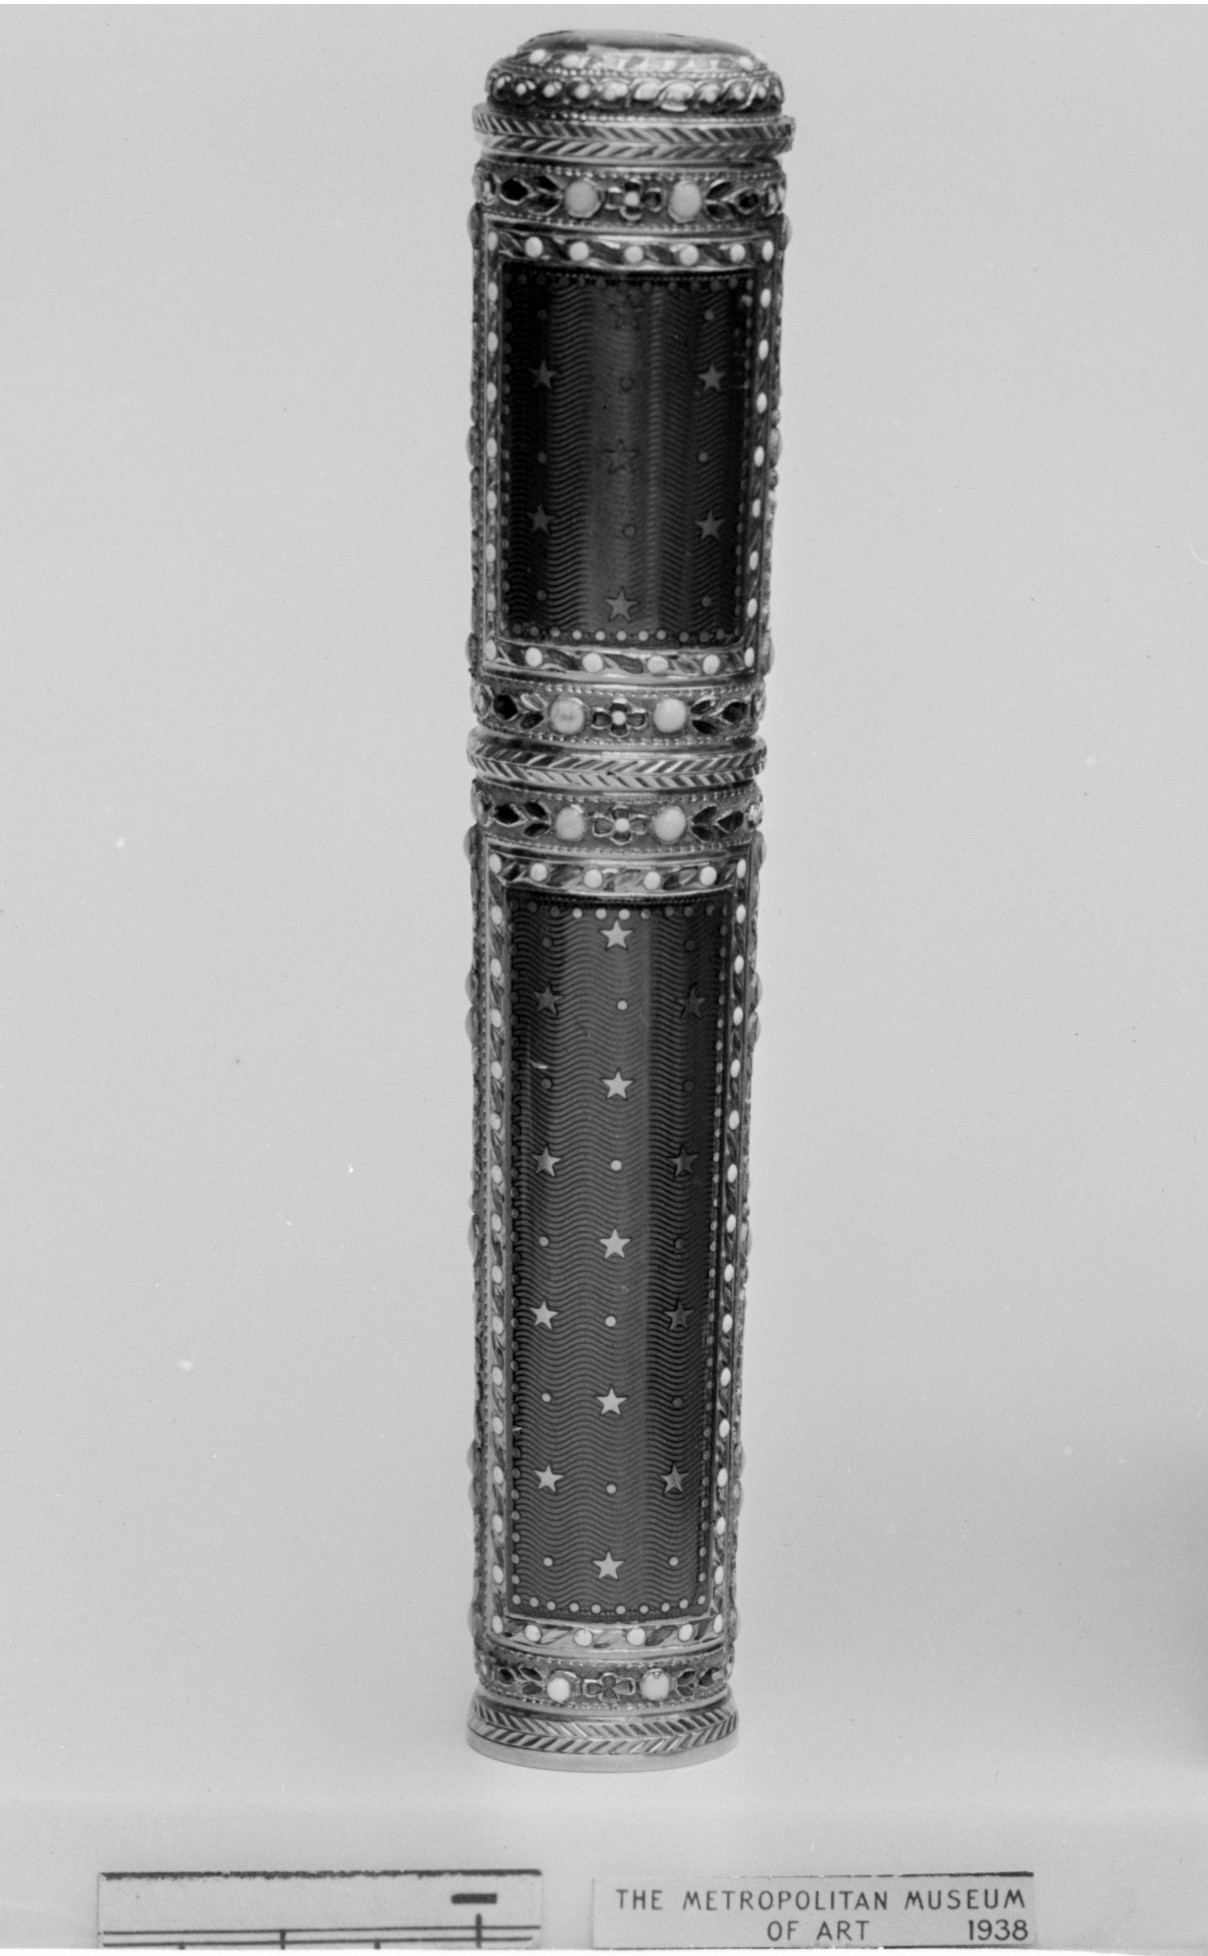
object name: étui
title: Sealing wax case (étui)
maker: joseph etienne blerzy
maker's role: artist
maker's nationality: french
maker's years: 1750-1806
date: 1783-1784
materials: enamel, gold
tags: stars